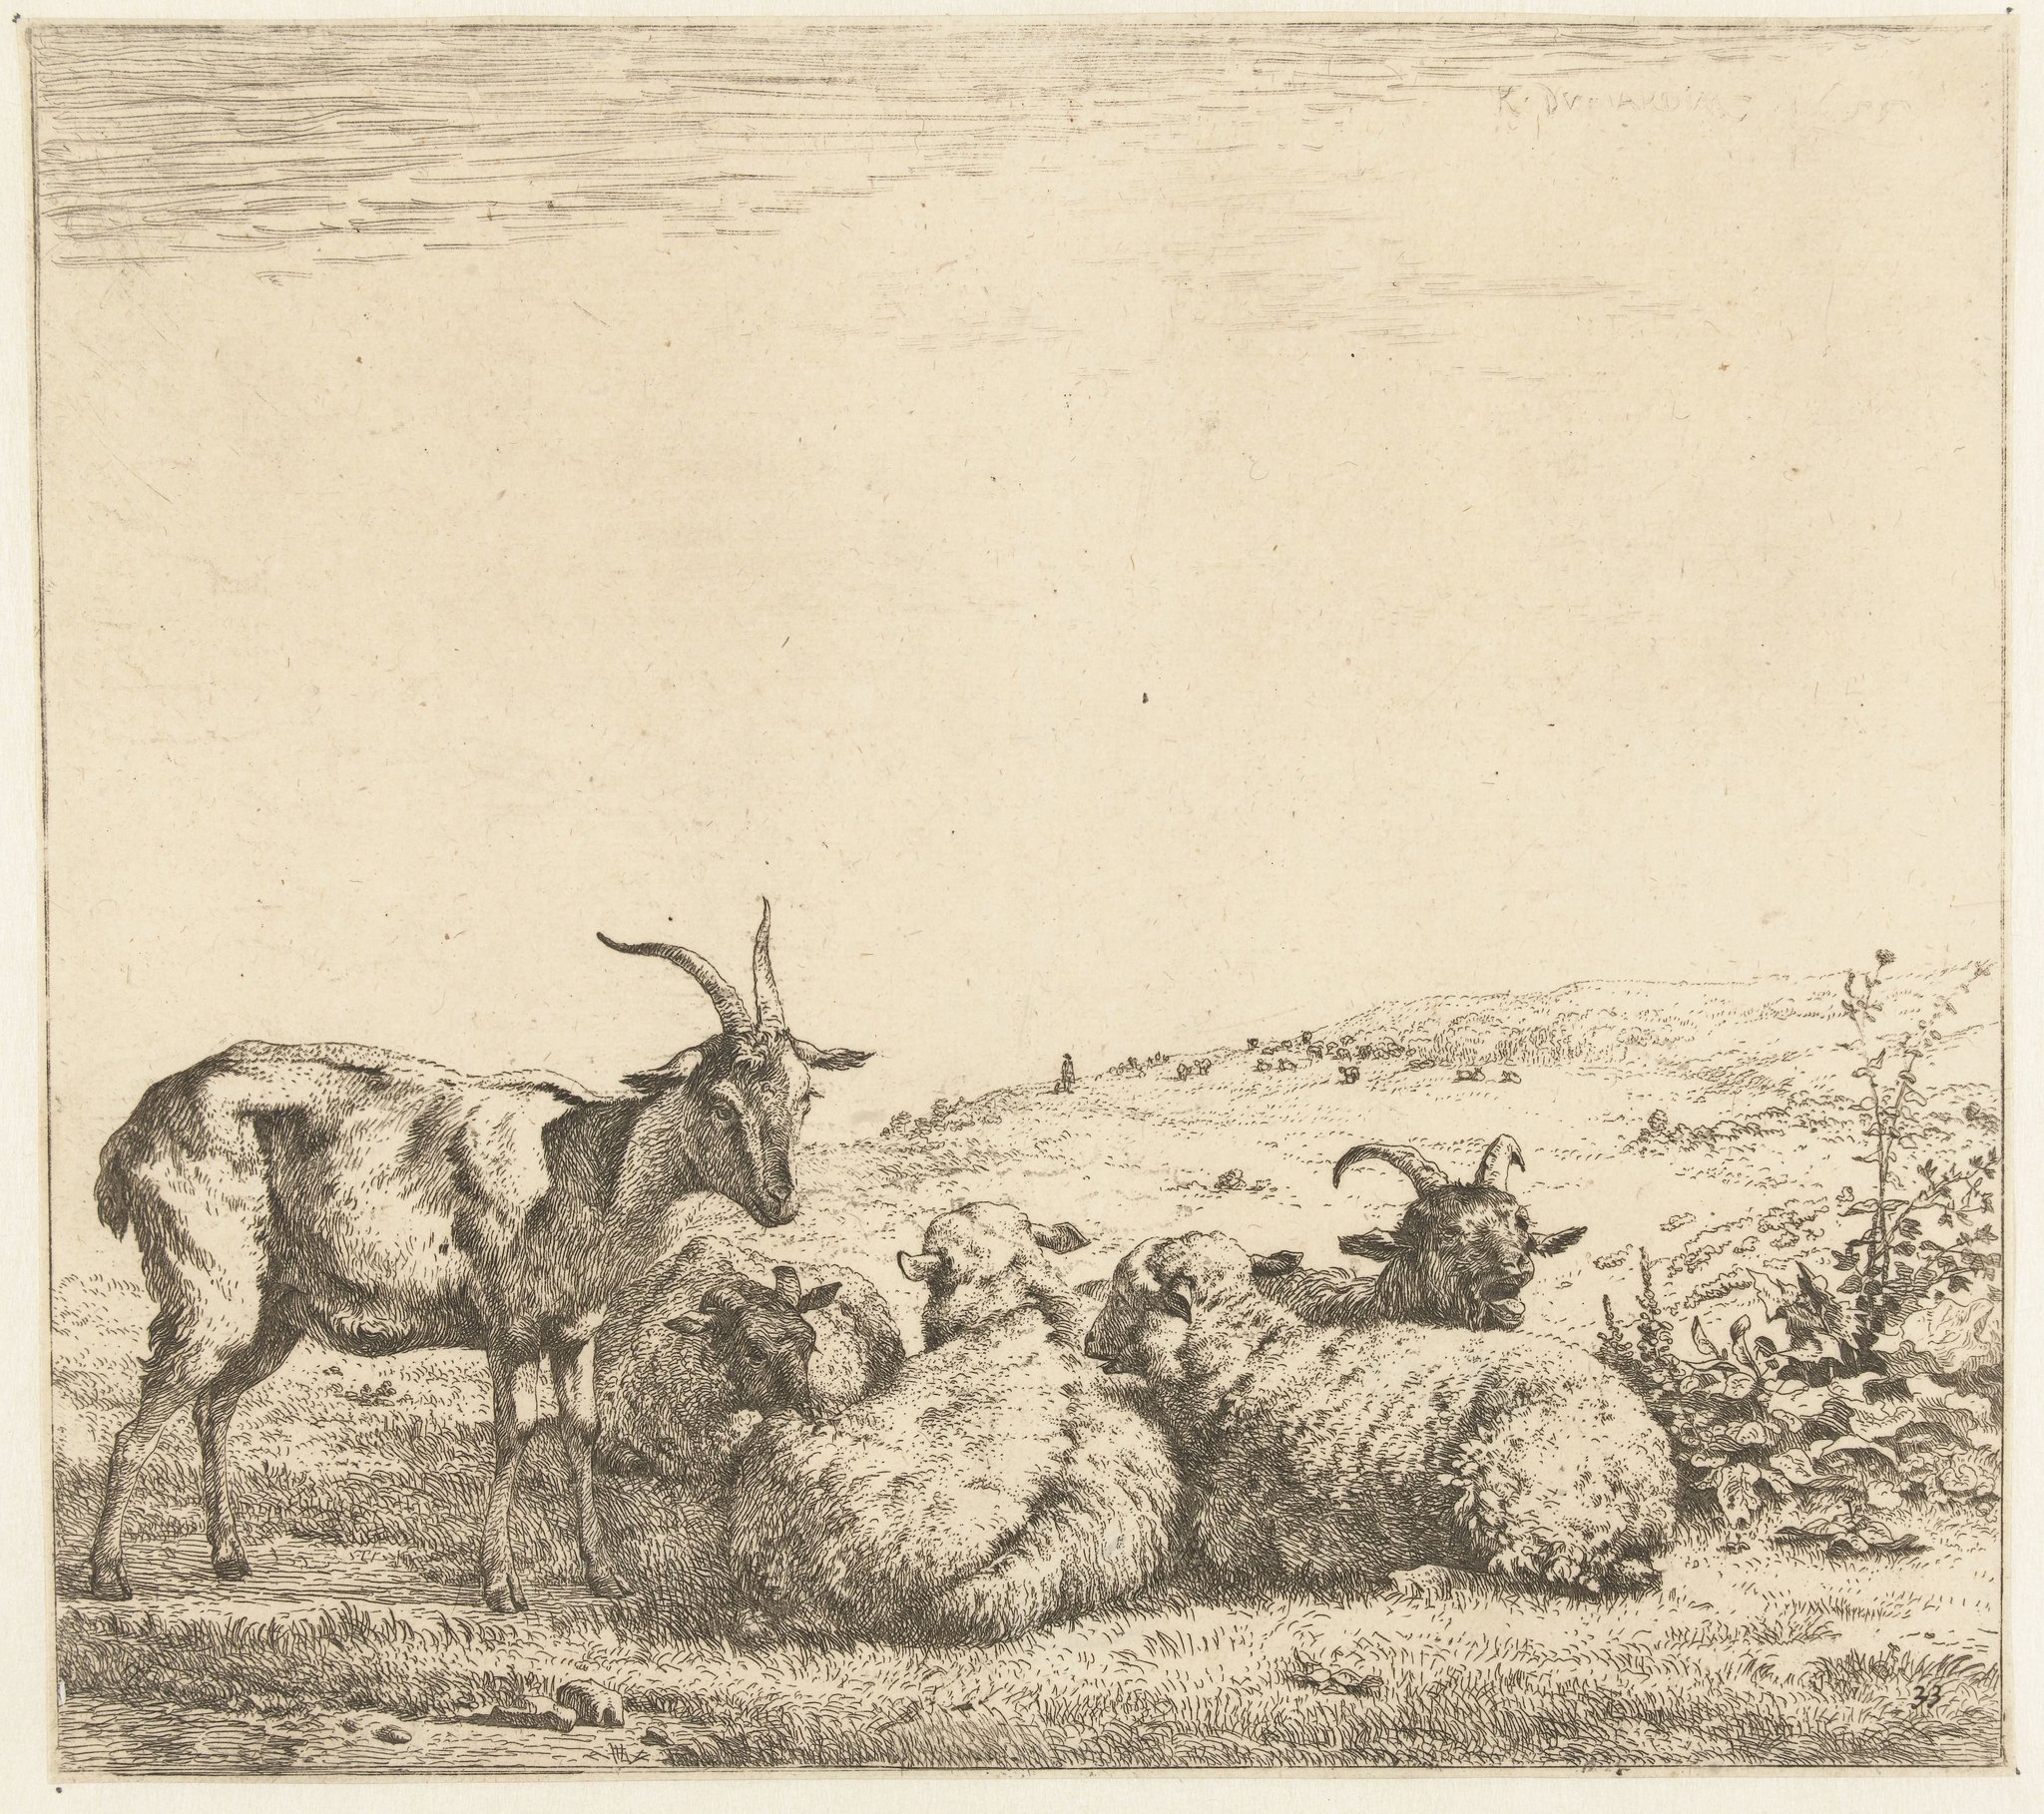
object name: print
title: Twee geiten en drie schapen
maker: karel du jardin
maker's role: draughtsman, painter, print maker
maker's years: 1626-1678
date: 1655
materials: paper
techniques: etching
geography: amsterdam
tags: sheep, goat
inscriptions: collector's mark: Lugt 2228a